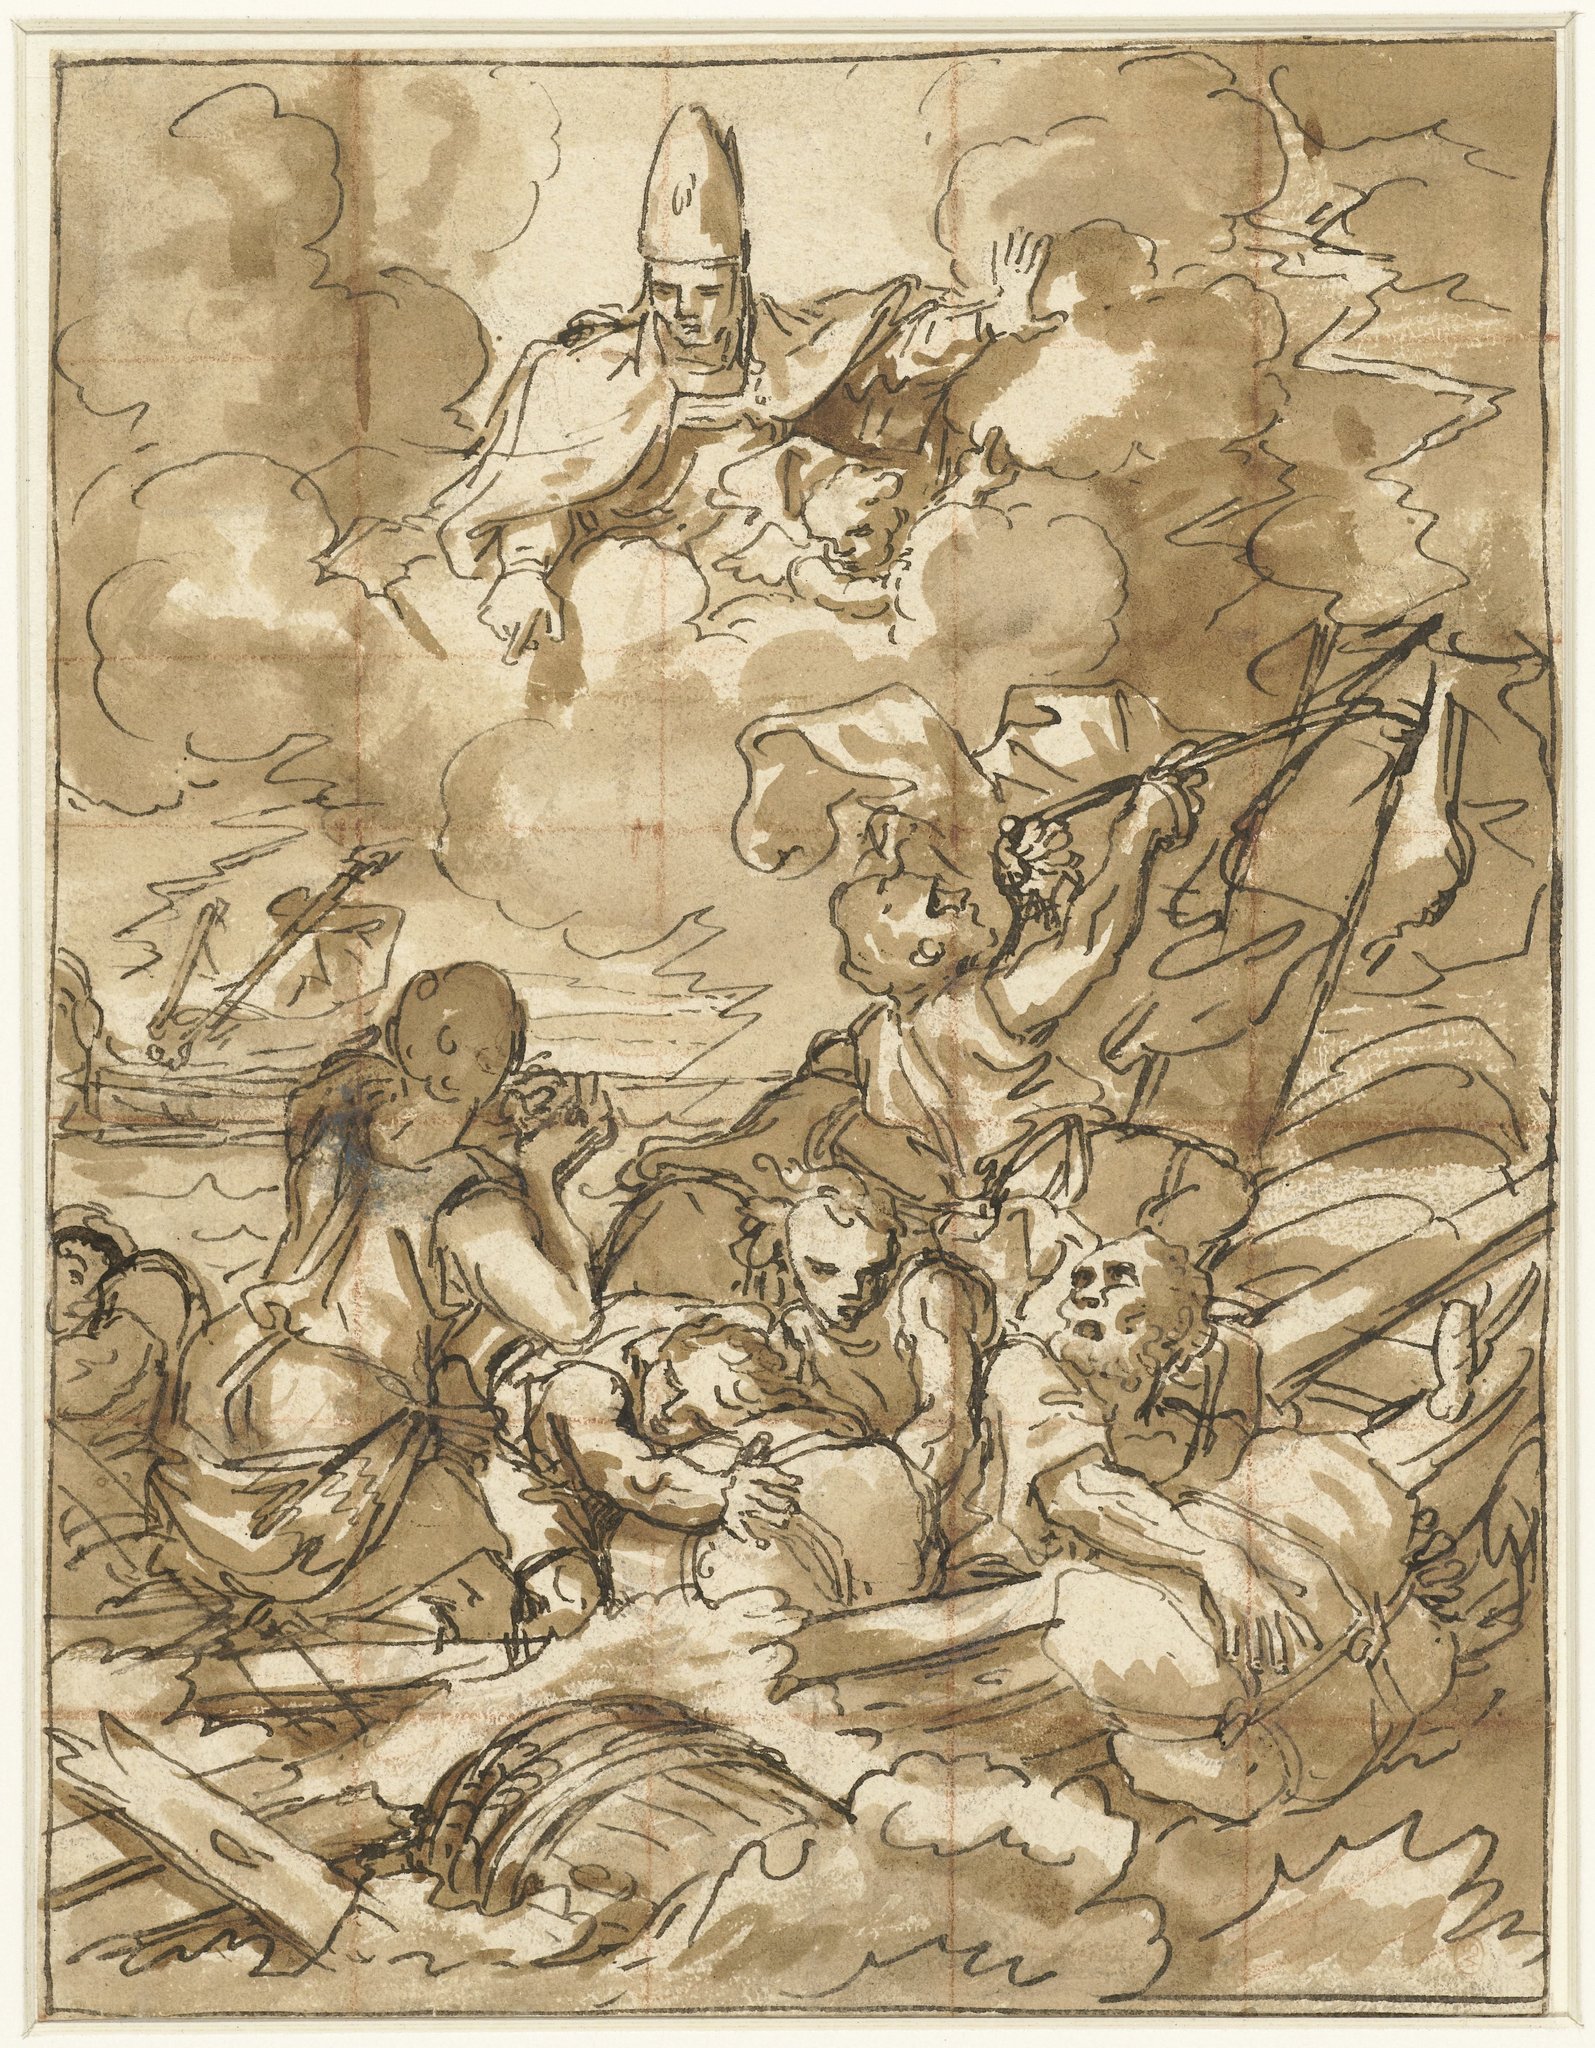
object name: drawing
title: Sint Nicolaas doet de storm op zee bedaren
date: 1600-1699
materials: paper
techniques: brush, pen, drawing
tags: st. nicholas, invoked by sailors whose boat is sinking, appears in the sky and calms the waves